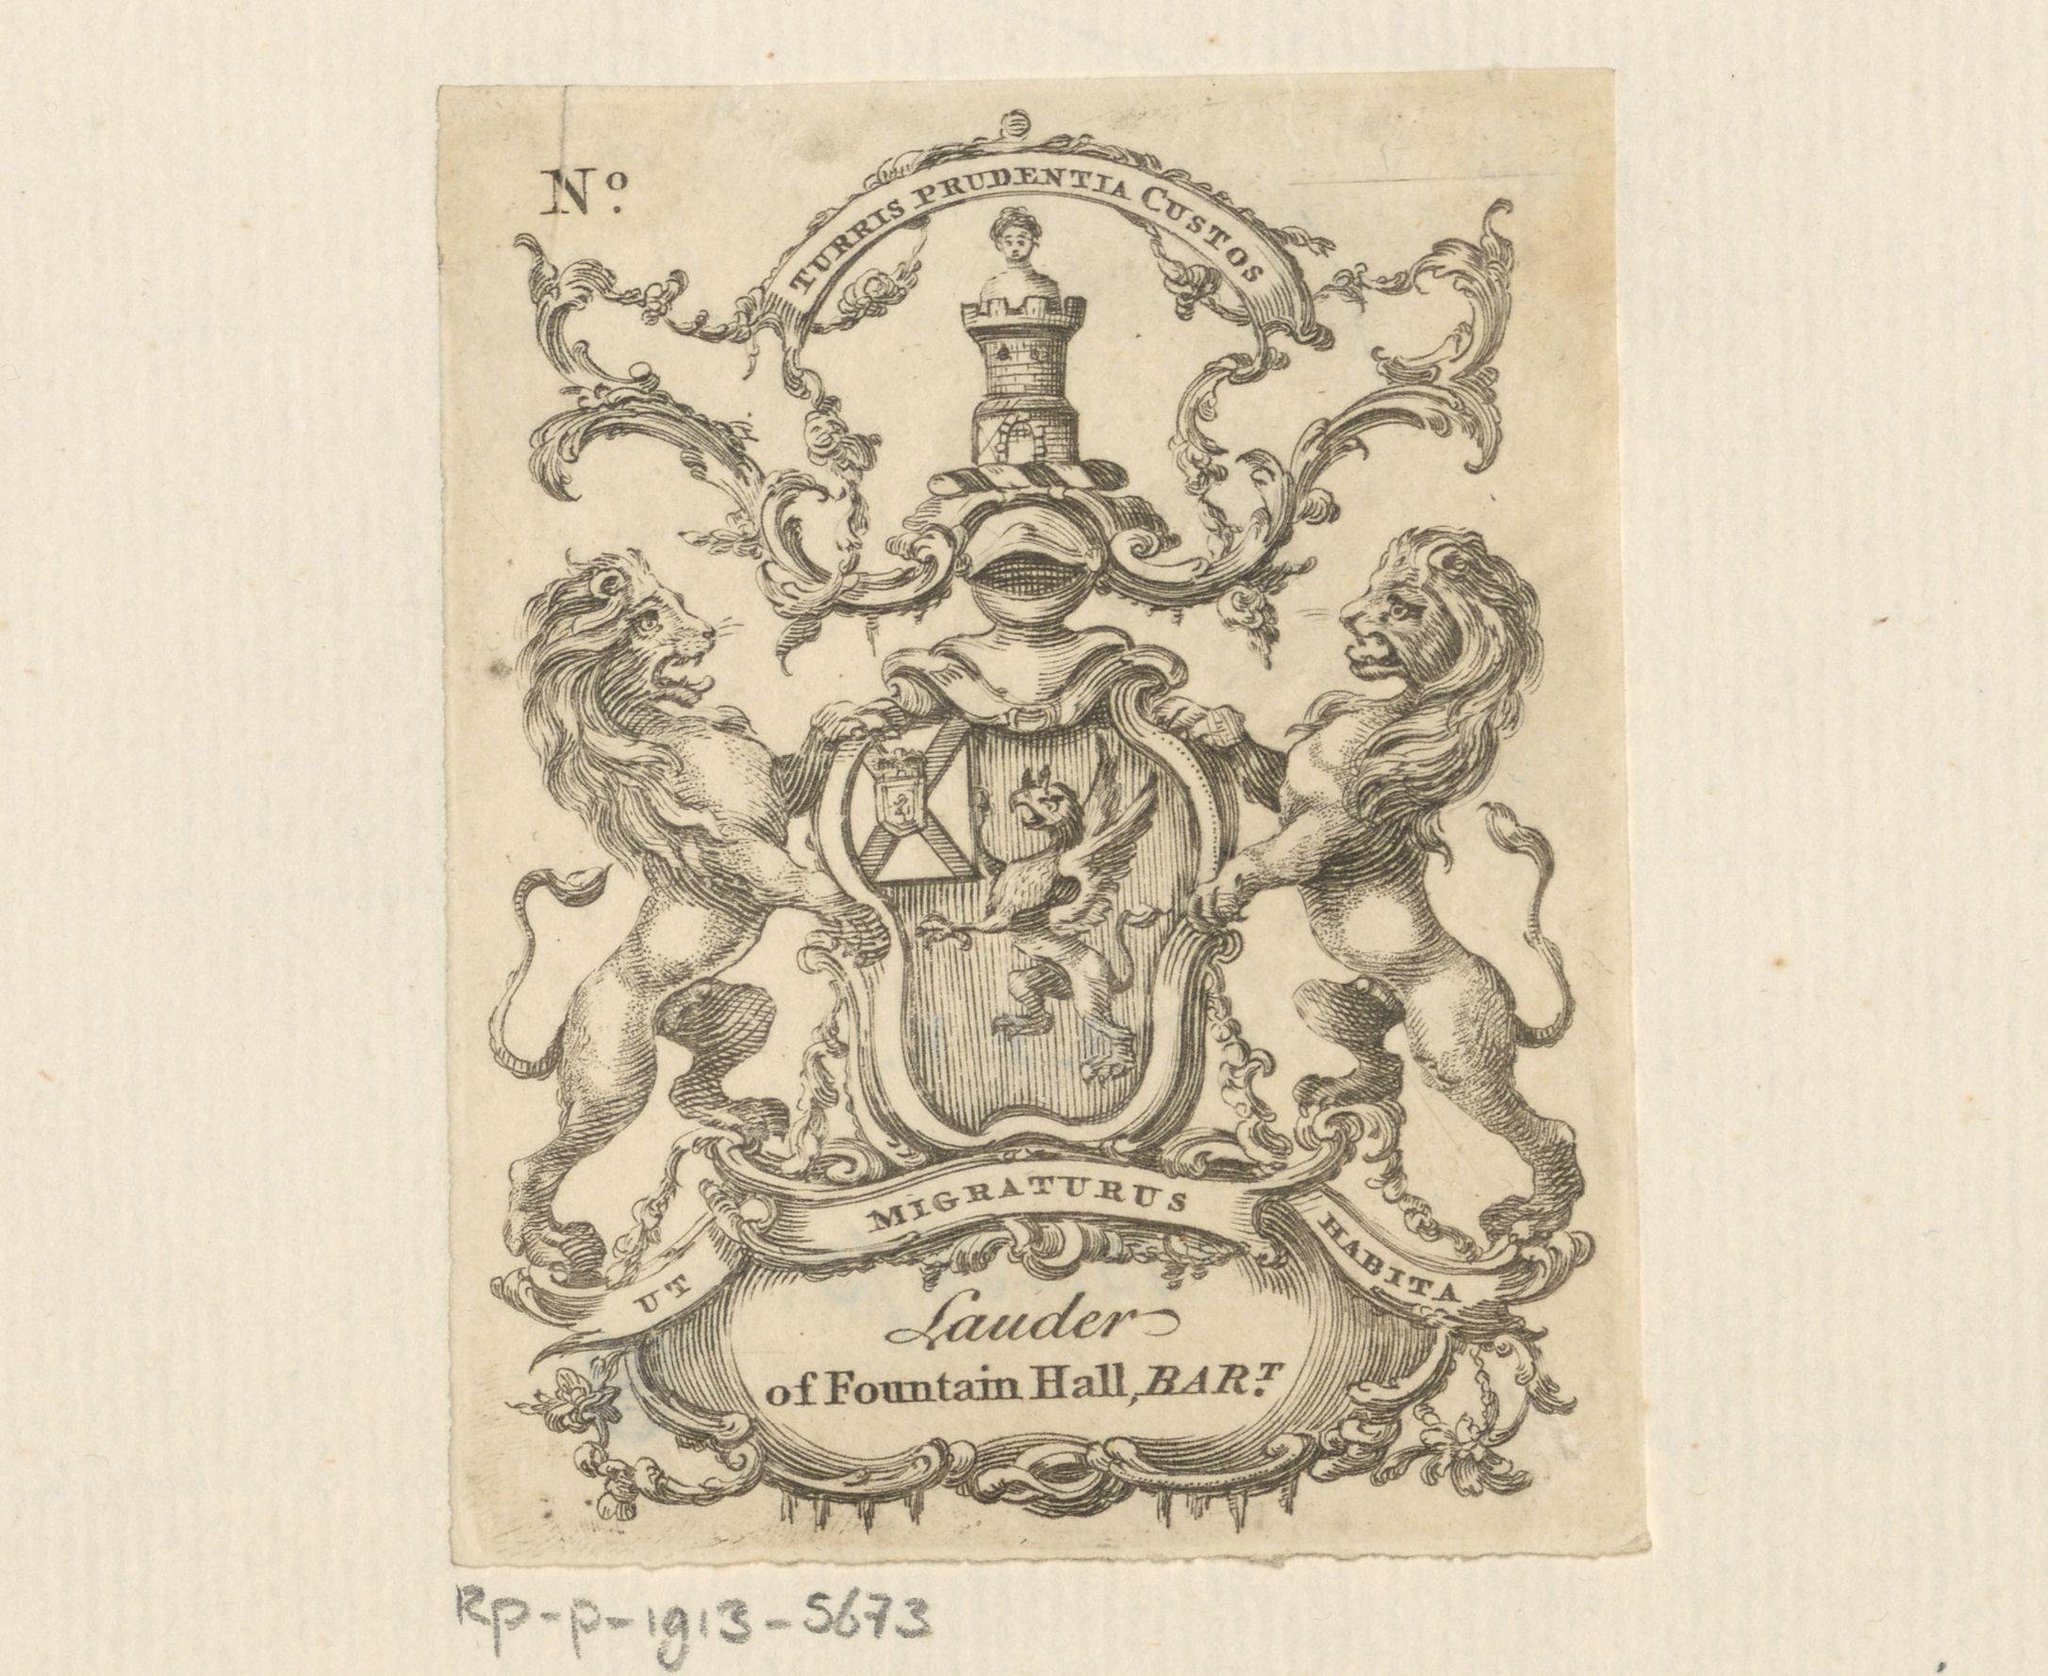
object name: bookplate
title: Ex libris van Lauder of Fountain Hall, Bart.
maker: Anonymous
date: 1750-1849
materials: paper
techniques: engraving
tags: armorial bearing, heraldry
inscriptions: collector's mark: Lugt 2233, collector's mark: Lugt 2760